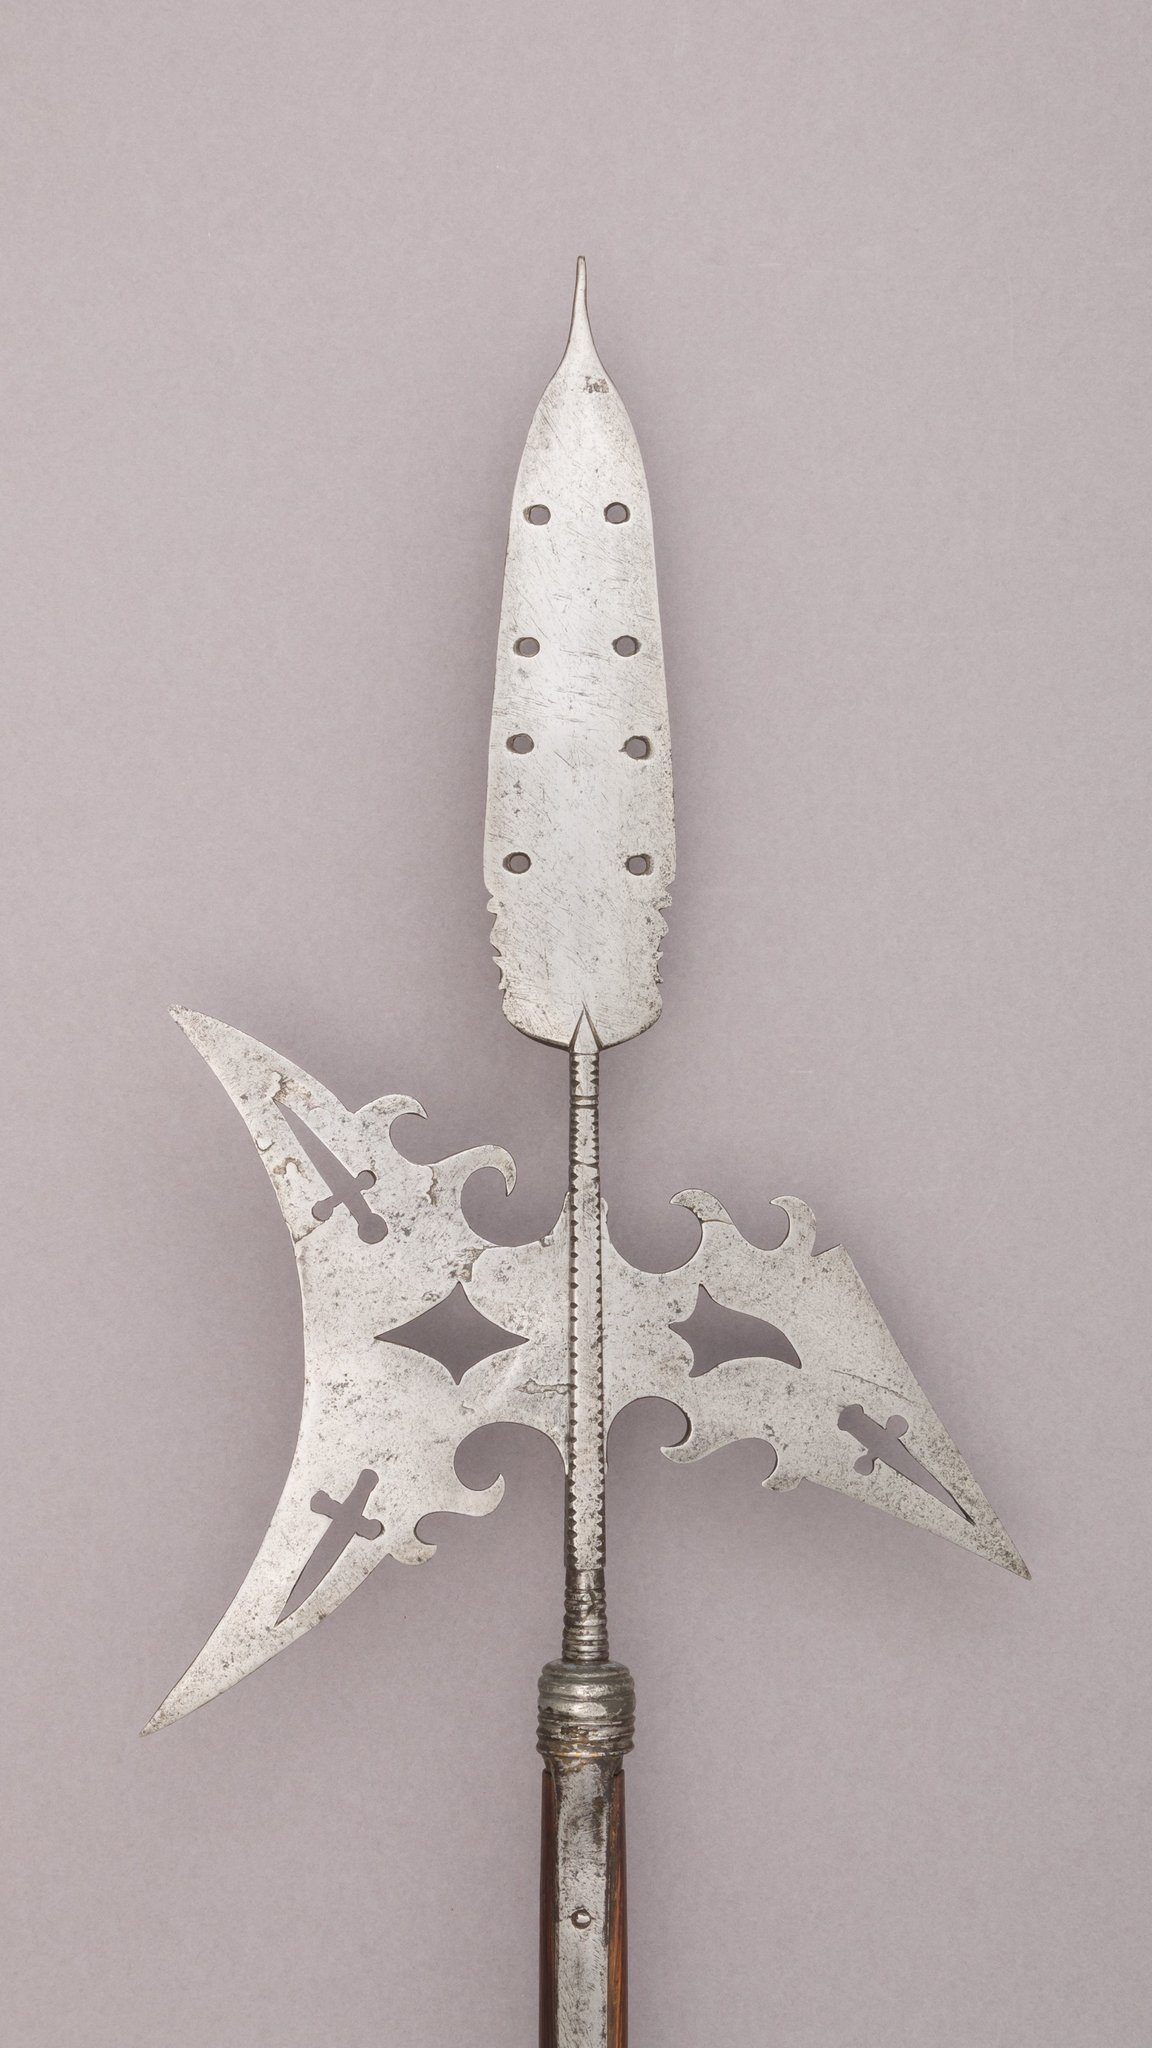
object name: halberd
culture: american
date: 1760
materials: steel, wood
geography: united states